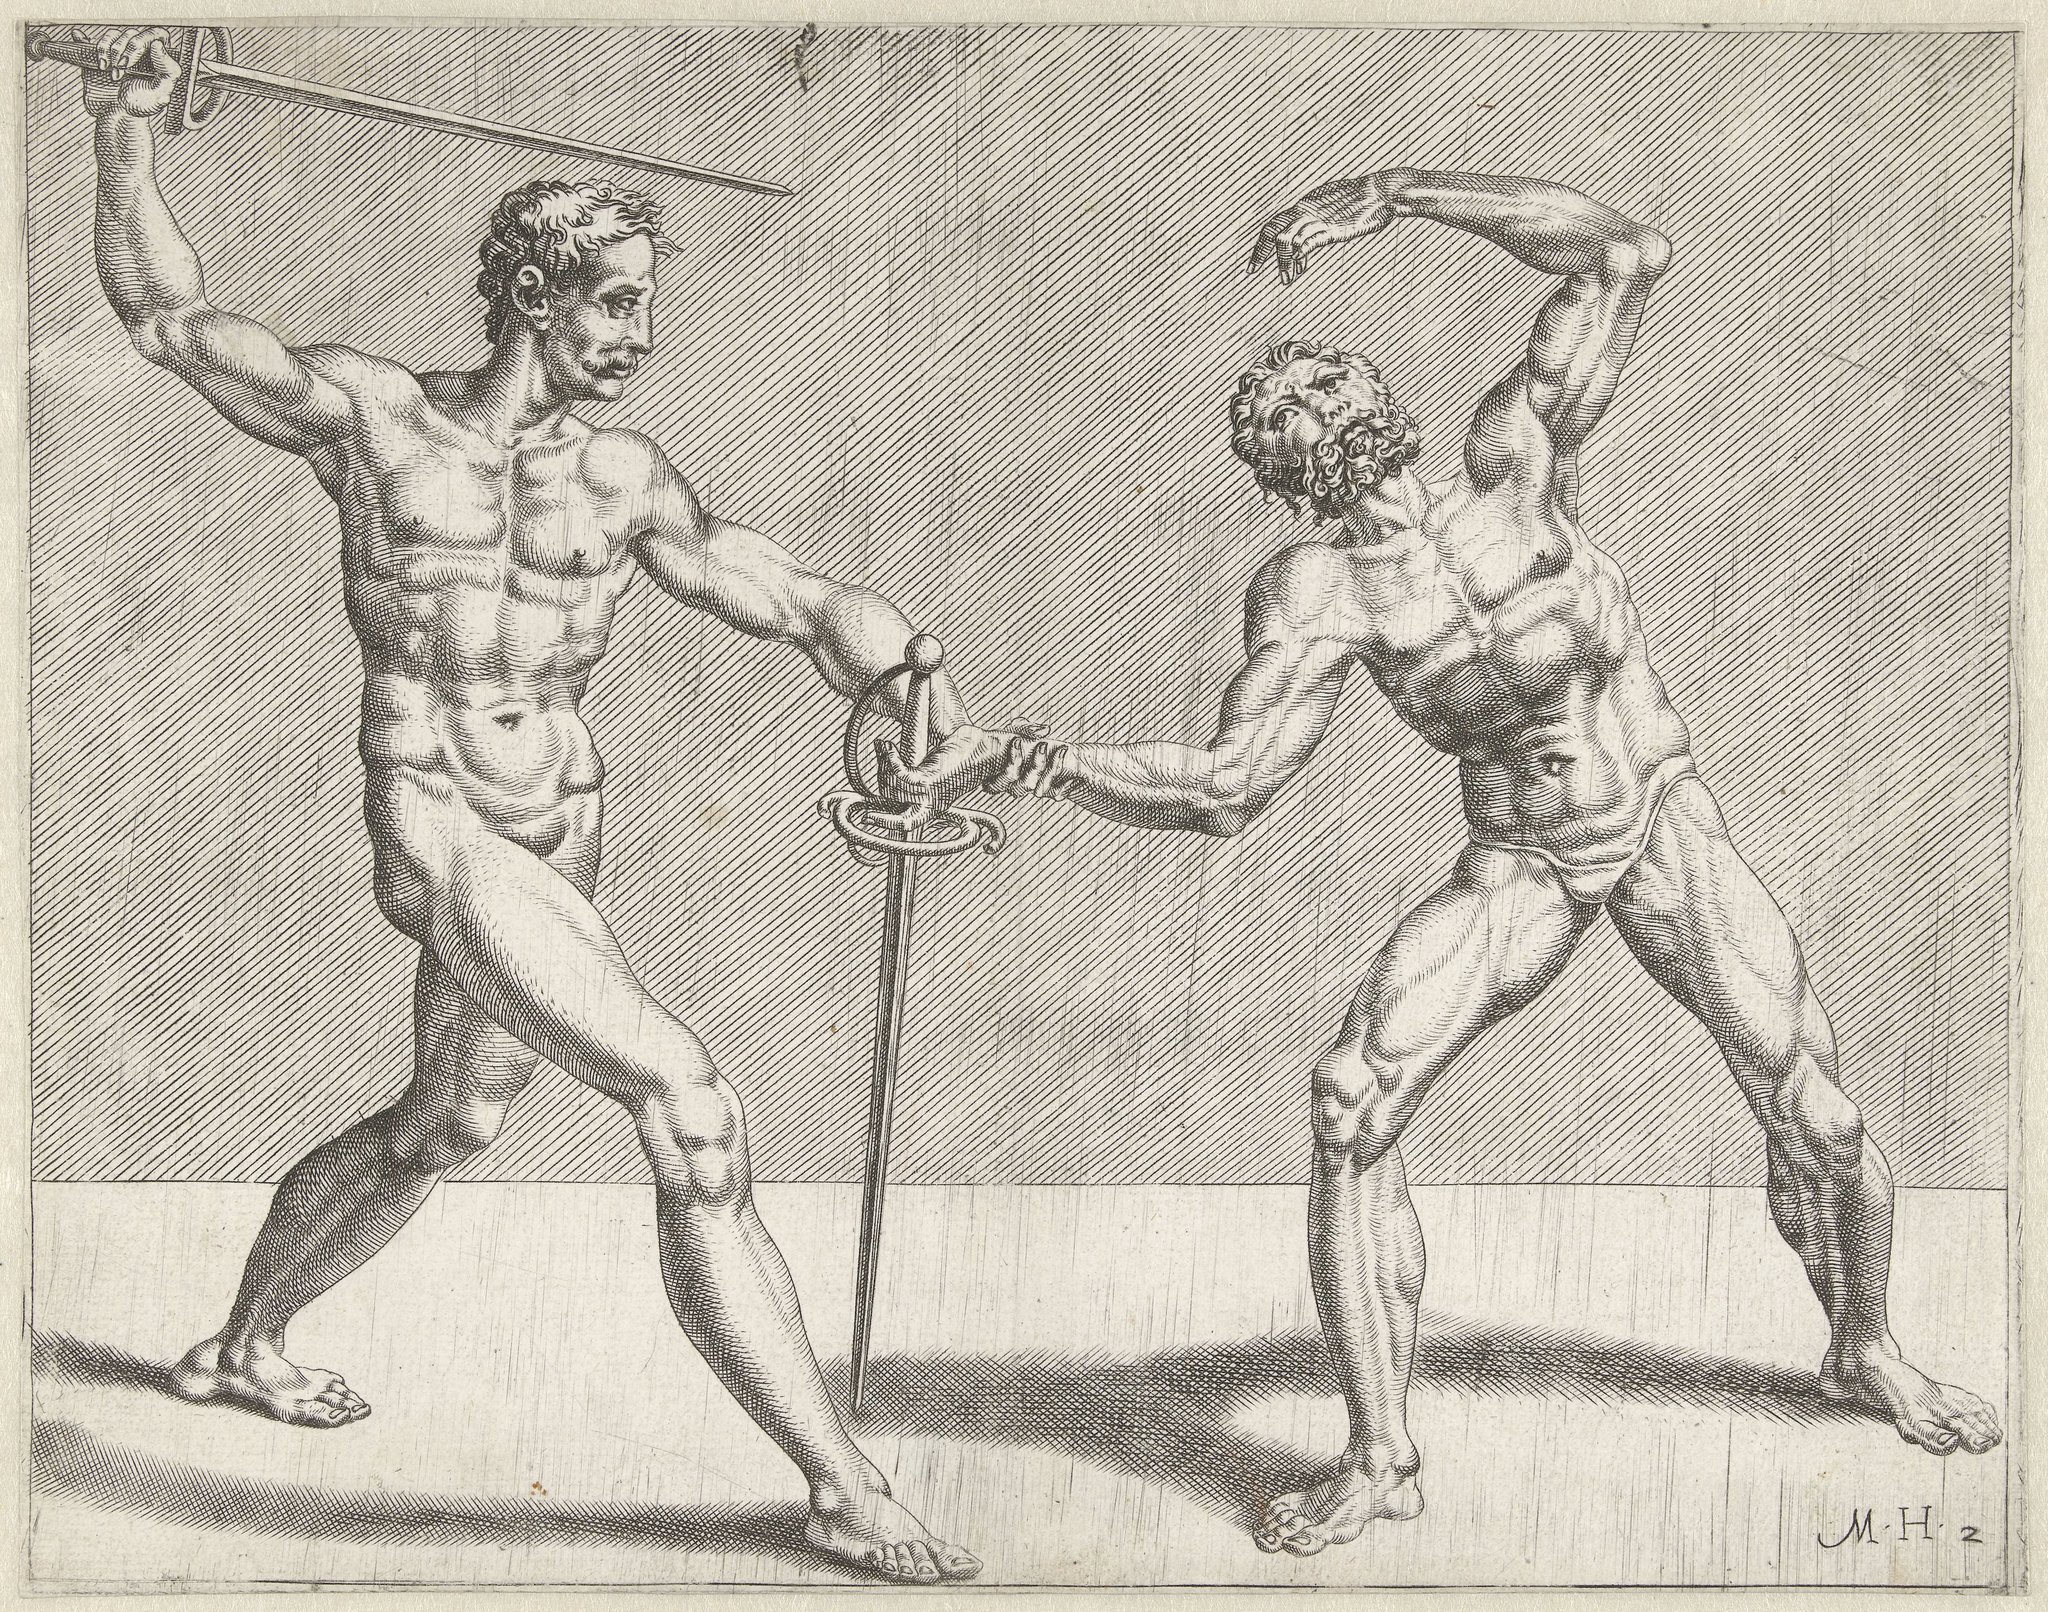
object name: print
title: Twee zwaardvechters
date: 1552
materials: paper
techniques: engraving, etching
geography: groningen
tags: fencing (sport)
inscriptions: collector's mark: Lugt 2228, collector's mark: Lugt 2760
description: Twee naakte zwaardvechters. De prent maakt deel uit van een serie over twee zwaardvechters in een tweekamp.